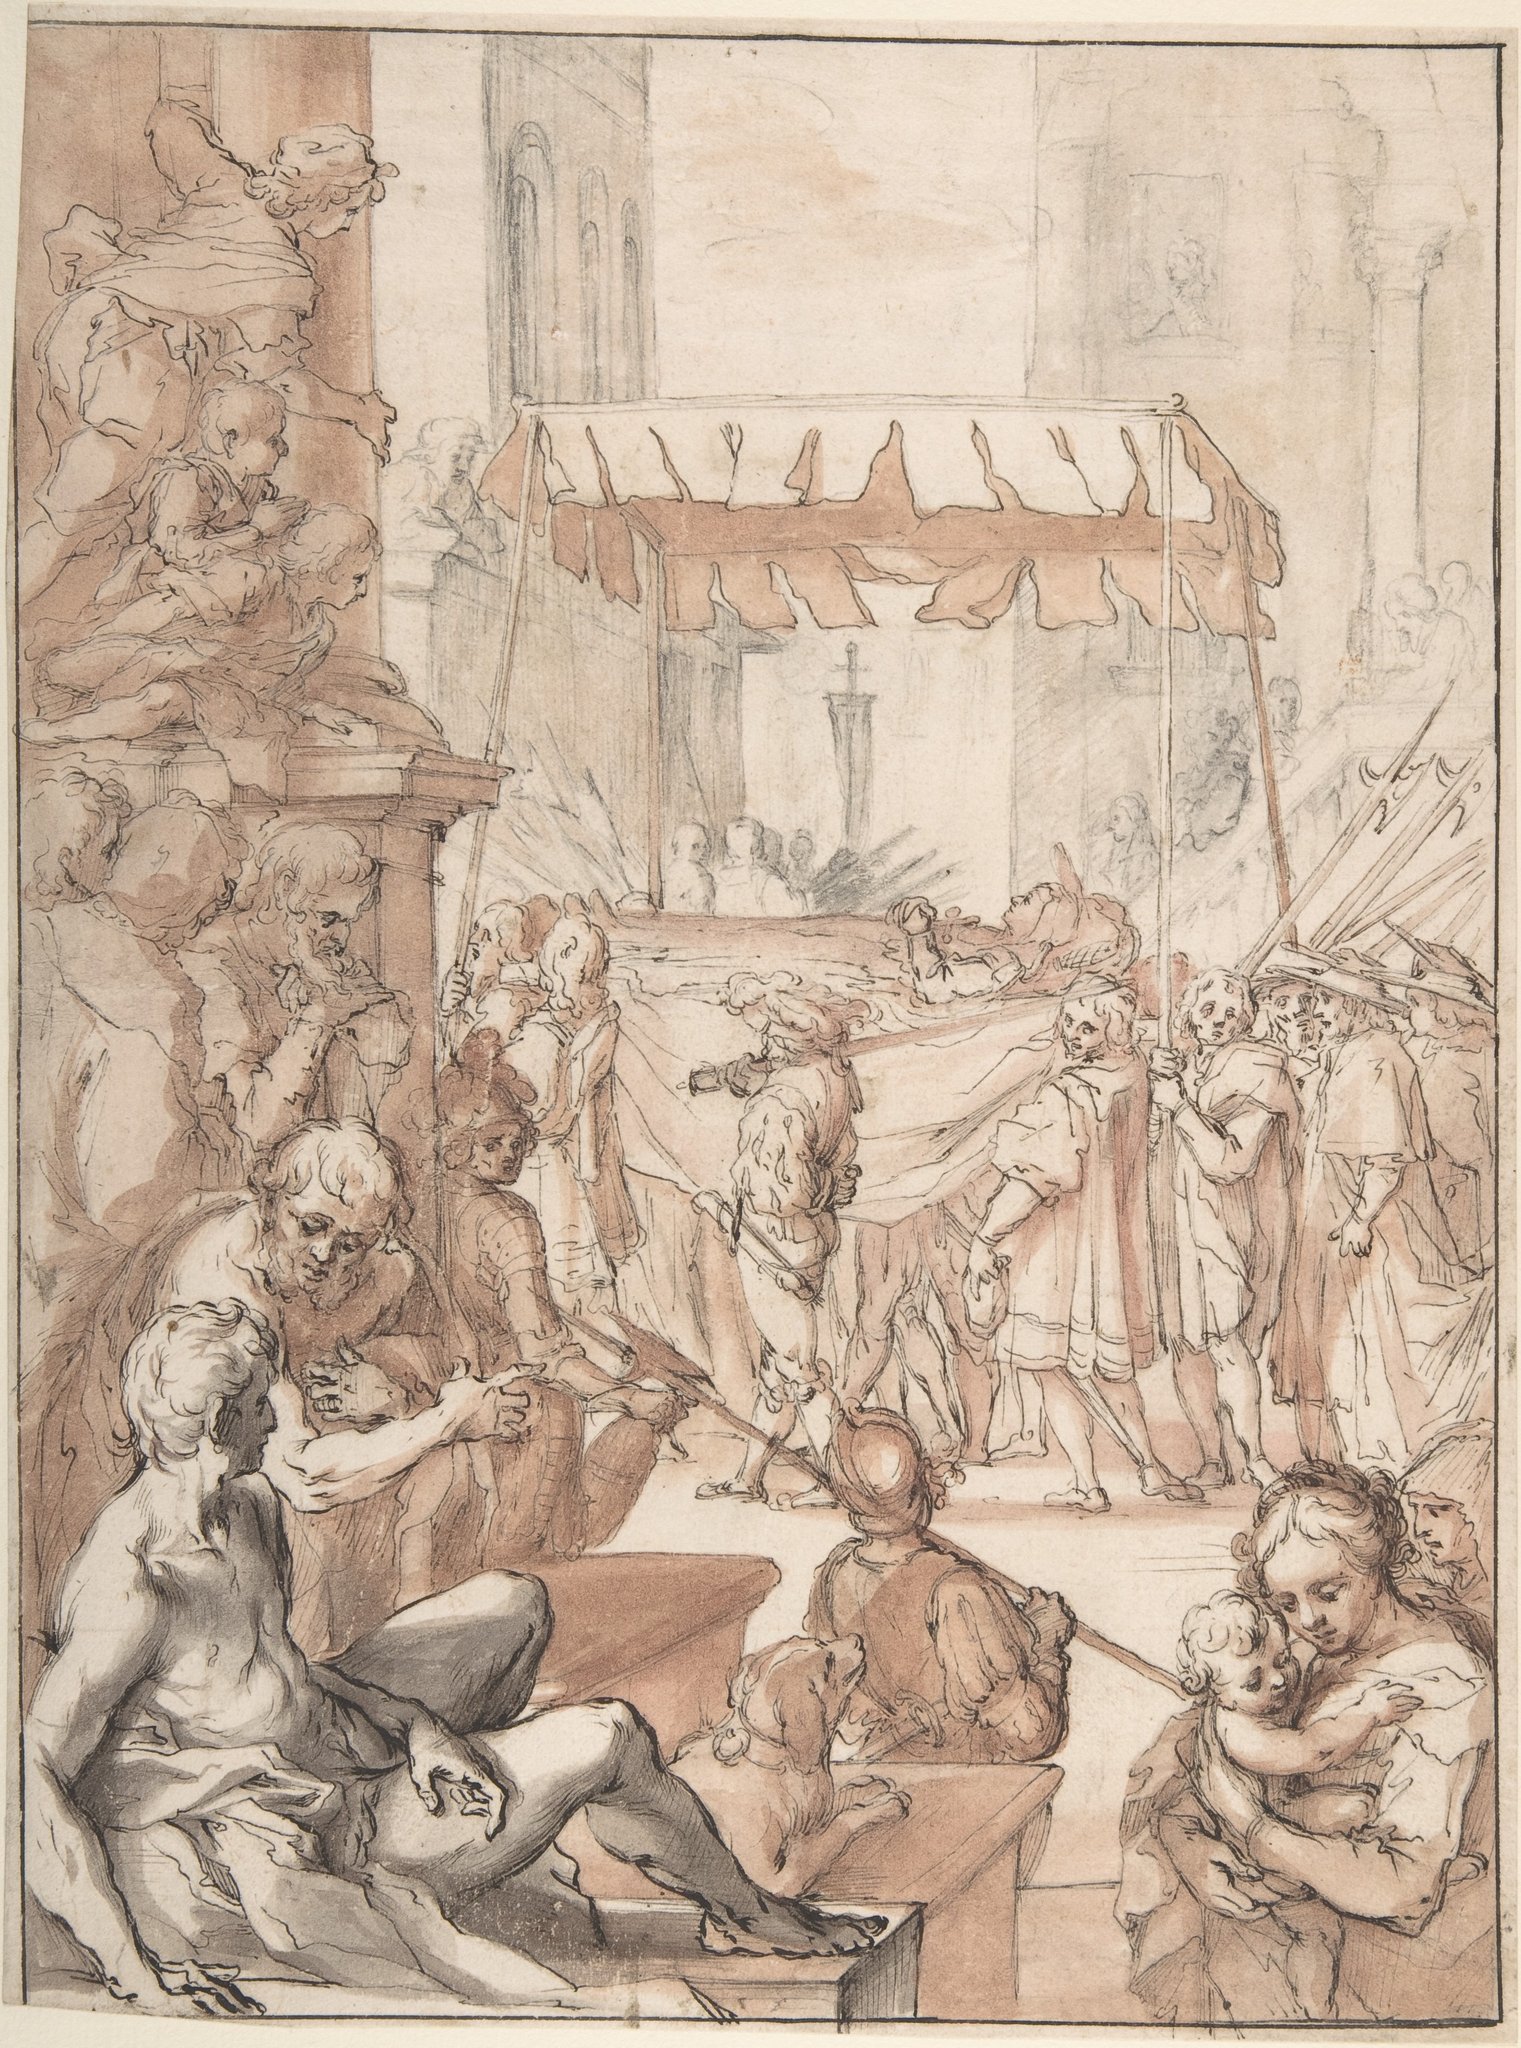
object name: drawing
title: The Body of Saint Catherine of Siena carried in Procession, after Francesco Vanni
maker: anonymous, french, 18th century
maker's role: artist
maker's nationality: french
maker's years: 1700-1800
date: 1701-1800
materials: chalk, ink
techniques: brush, pen, wash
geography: france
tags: infants,women,saint catherine,crowd,death